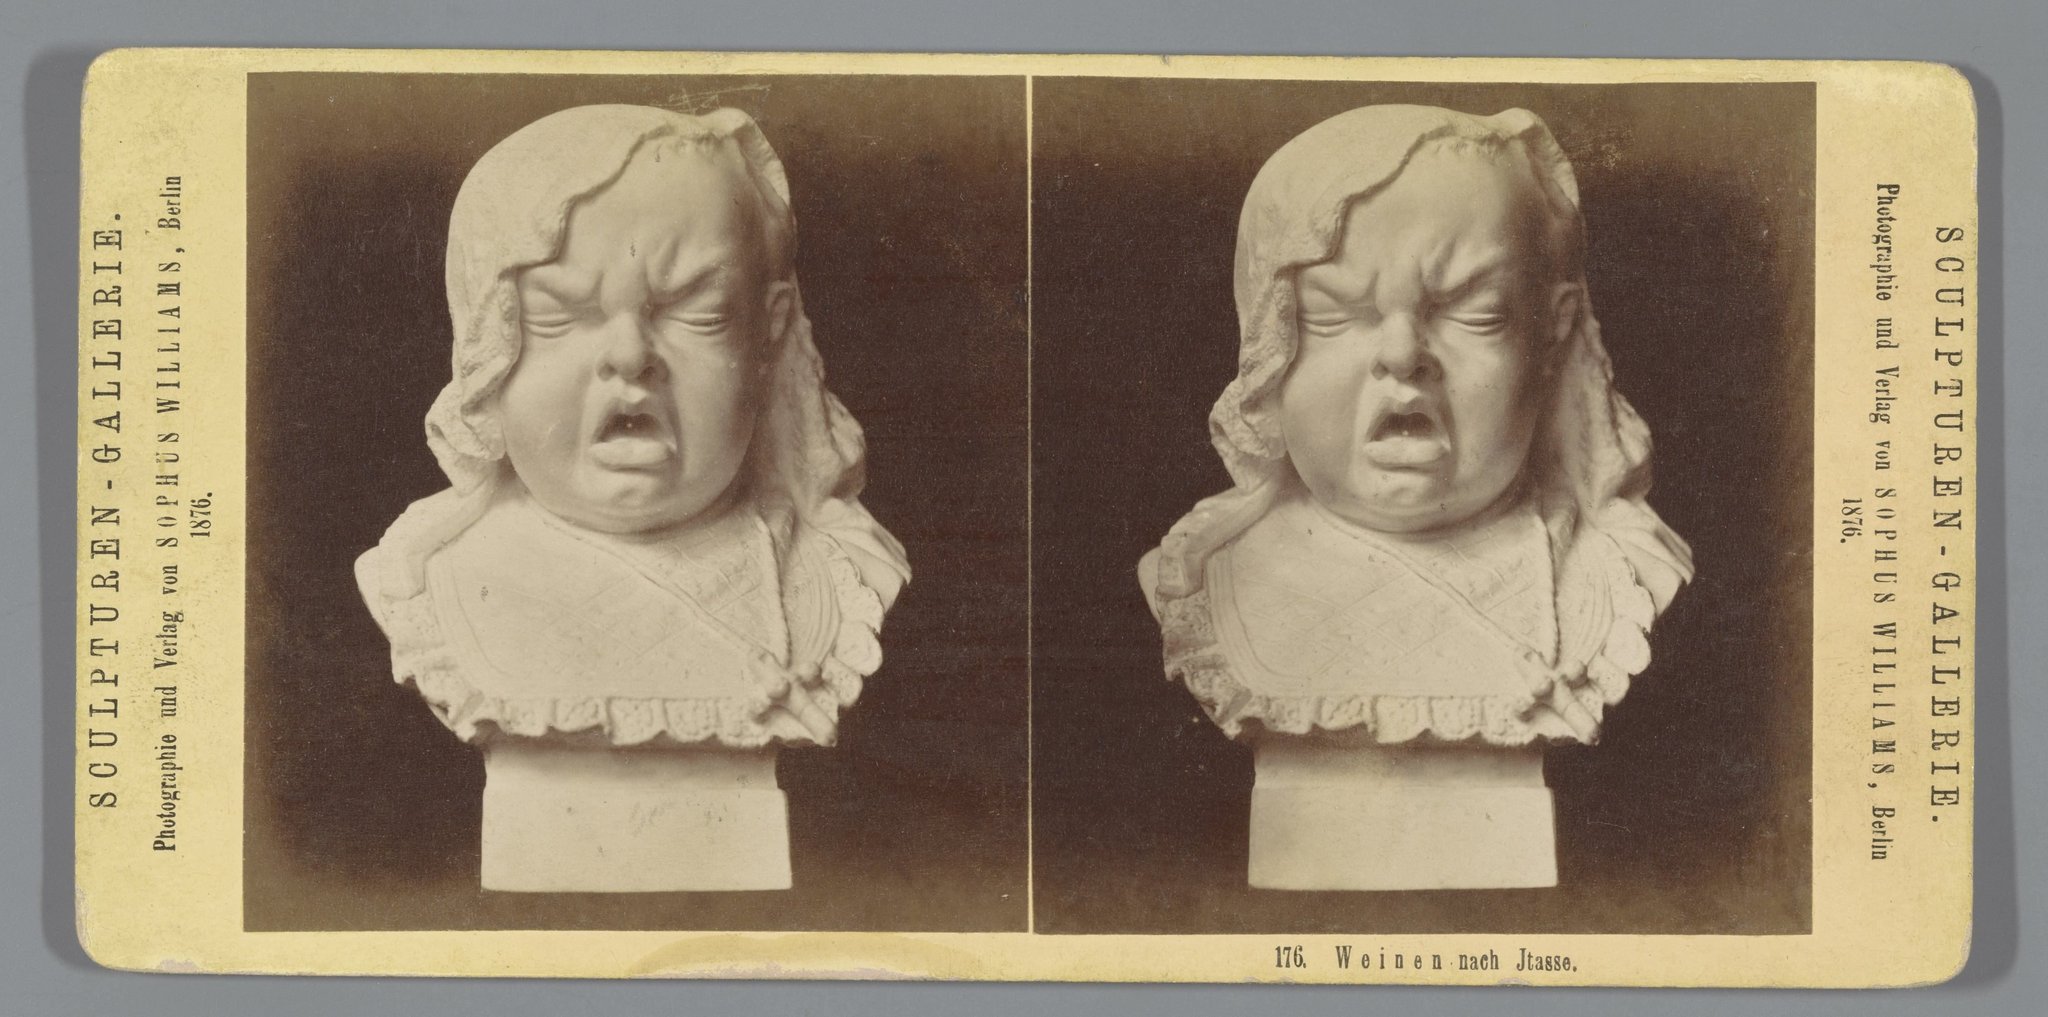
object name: stereograph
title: Sculptuur van een huilend kindergezicht naar Jtasse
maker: sophus williams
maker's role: publisher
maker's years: 1835-1900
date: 1876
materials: cardboard, photographic support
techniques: albumen print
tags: weeping, sculpture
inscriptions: number: ‘176’, : ‘Berlin’